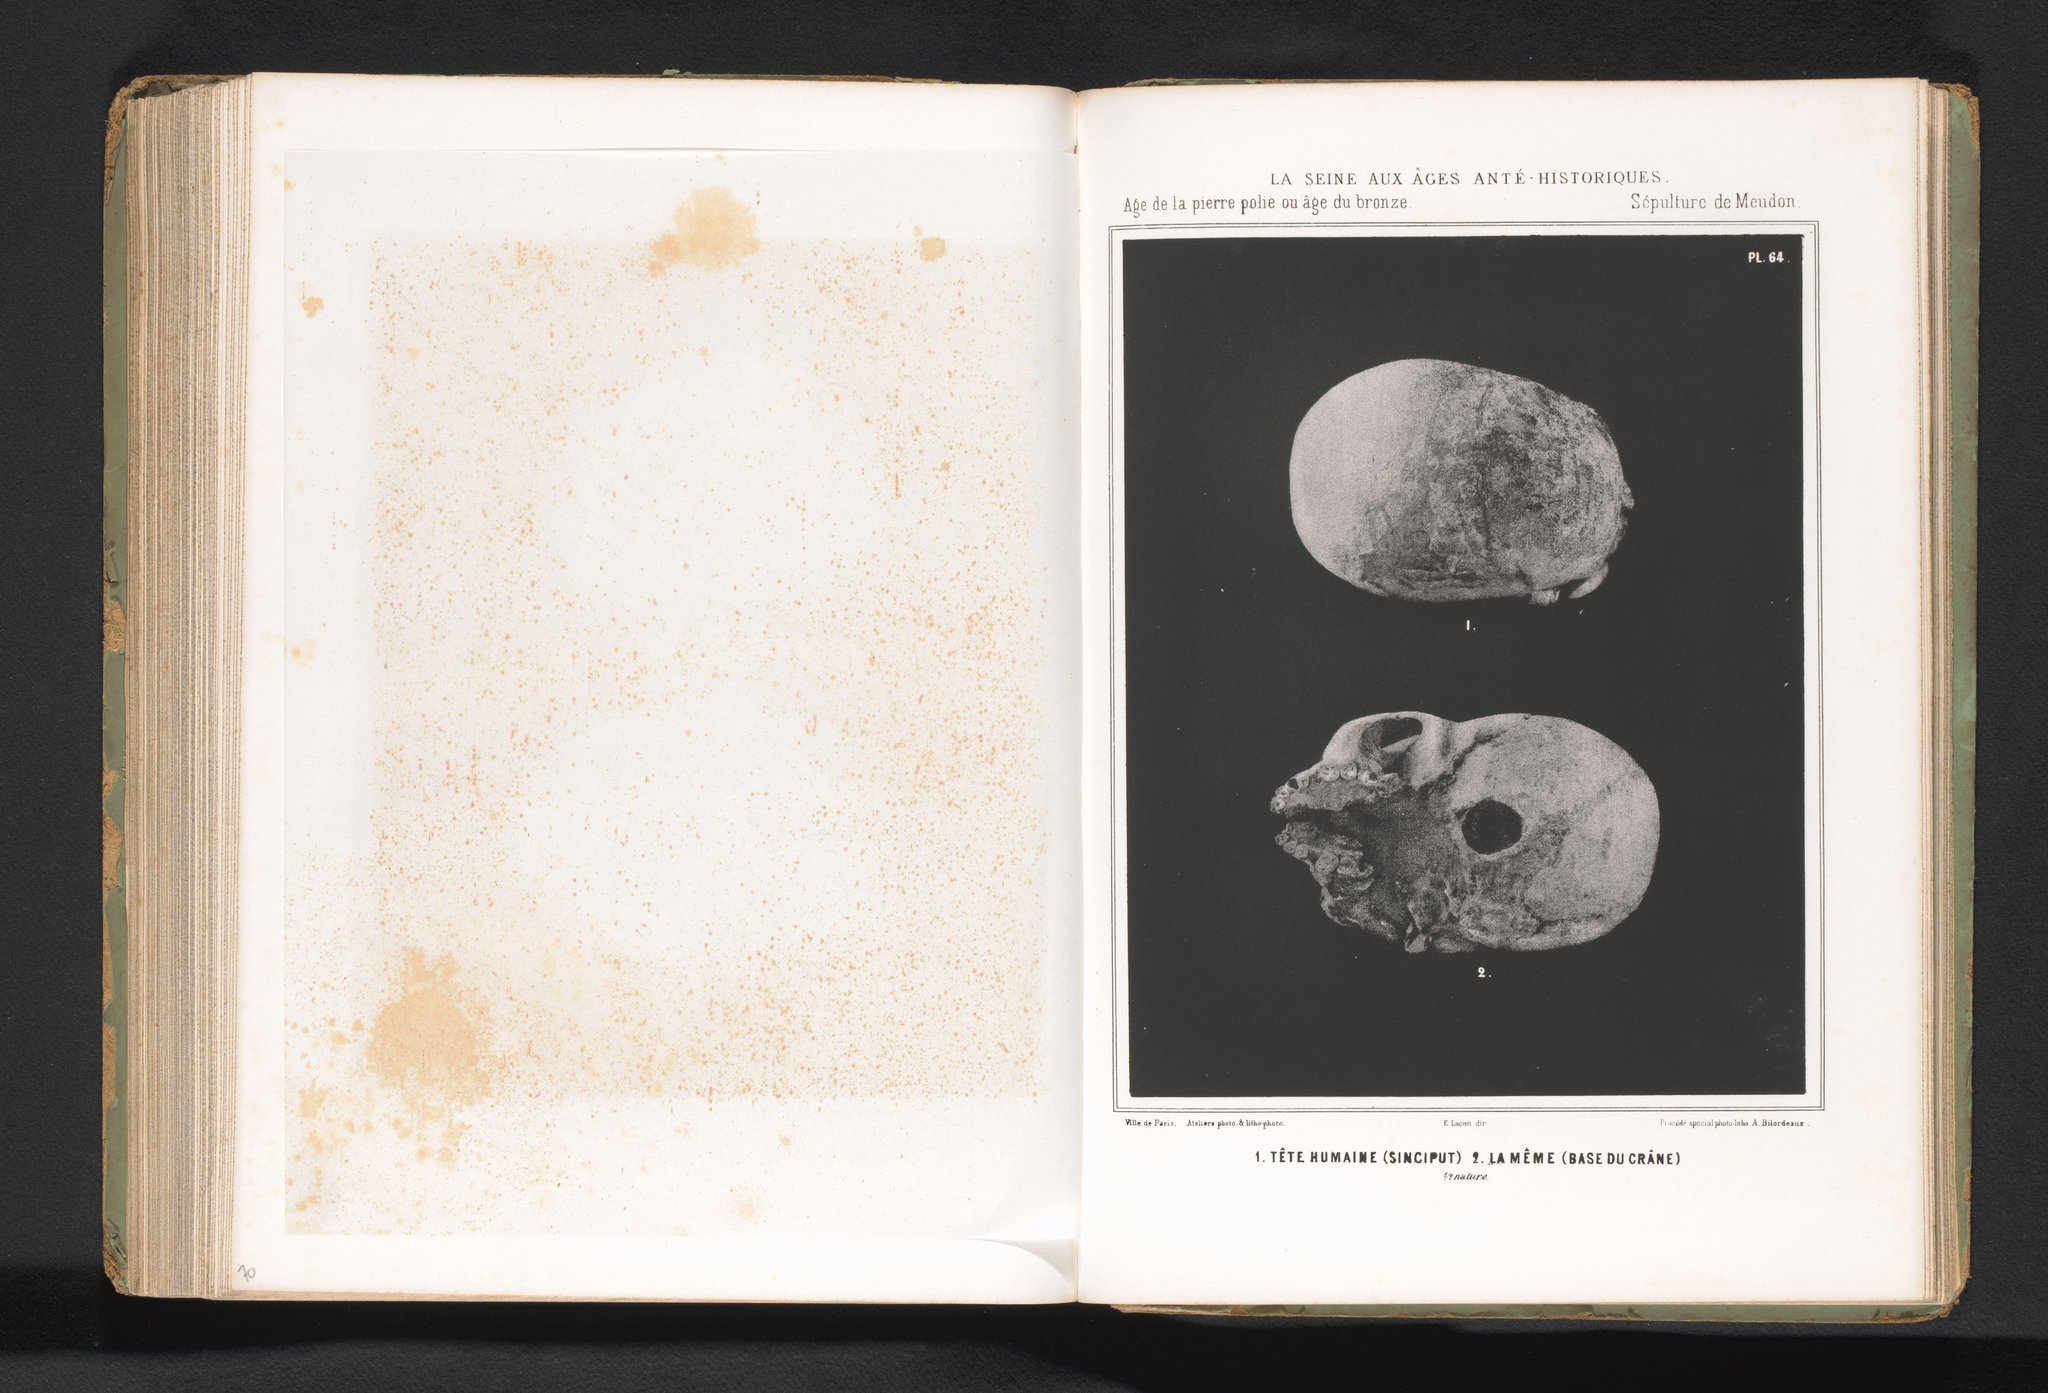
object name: page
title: Twee aanzichten van een menselijke schedel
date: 1864-1869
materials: paper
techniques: photolithography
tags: (human) skull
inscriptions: inscription: ‘1/2 nature’, inscription: ‘PL.64’, inscription: ‘1. TÊTE HUMAINE (SINCIPUT). 2. LA MÊME (BASE DU CRÂNE)’, inscription: ‘Procédé spécial photo-litho. A. Bilordeaux’